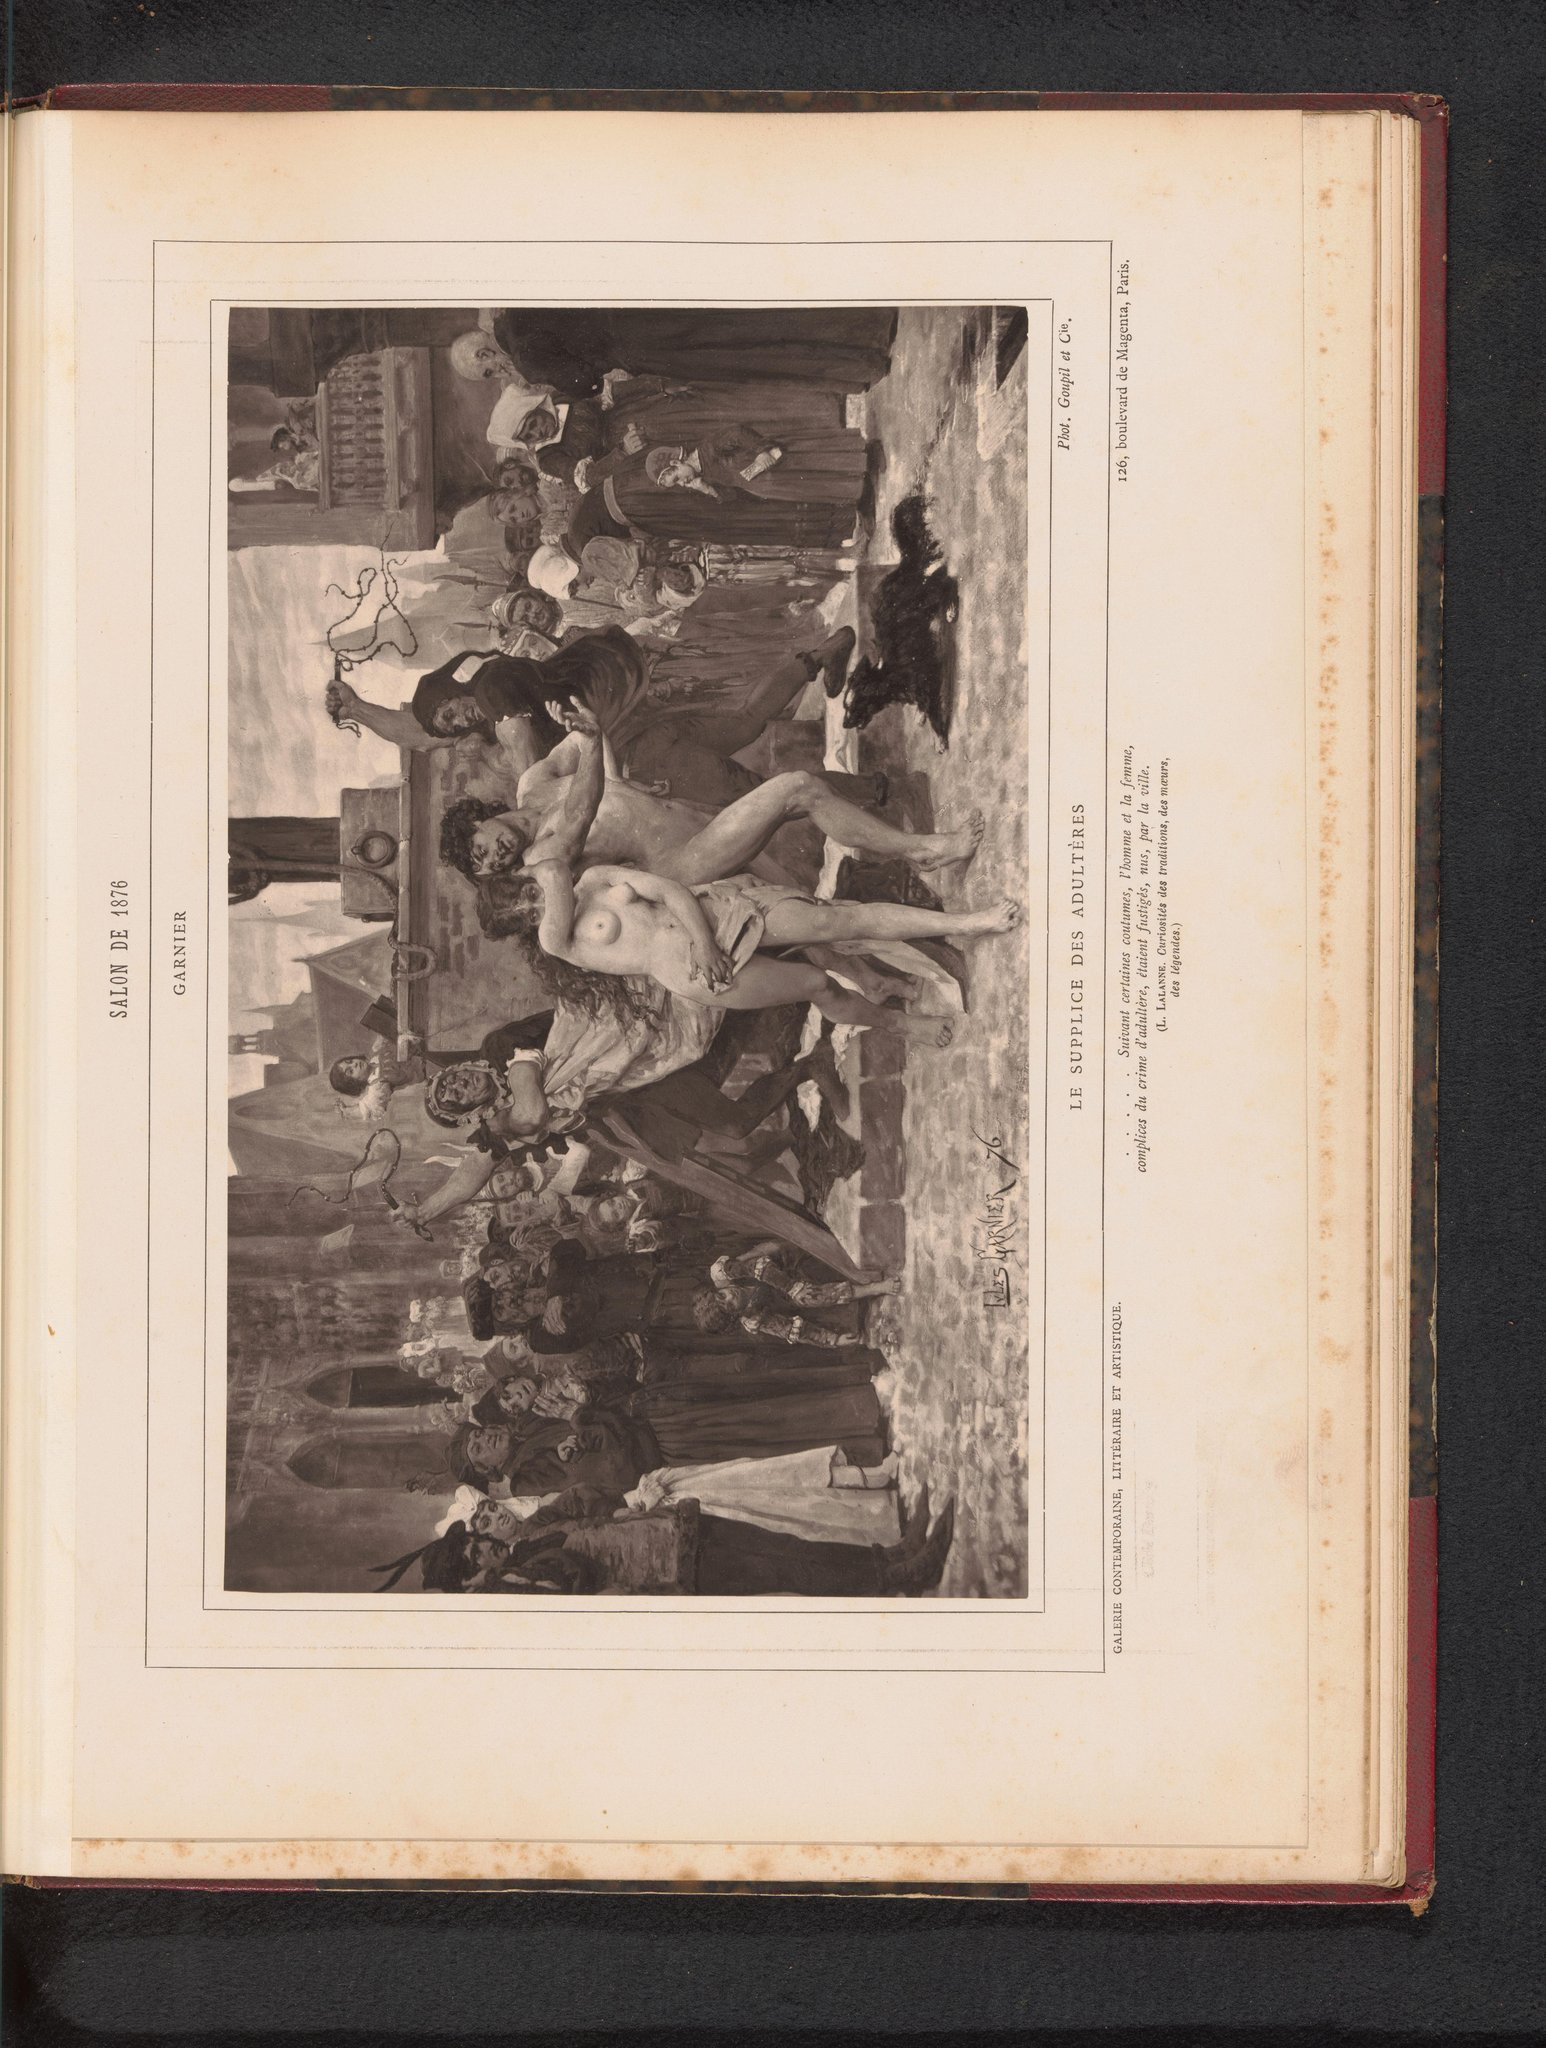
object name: reproduction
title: Reproductie van Le supplice des adultères door Jules-Arsène Garnier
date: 1871-1876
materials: paper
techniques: woodburytype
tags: adulterer, corporal punishment in public, painting, drawing and the graphic arts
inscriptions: inscription: ‘Salon de 1876/ Suivant certaines coutumes, l'homme et a femme, / (...)’